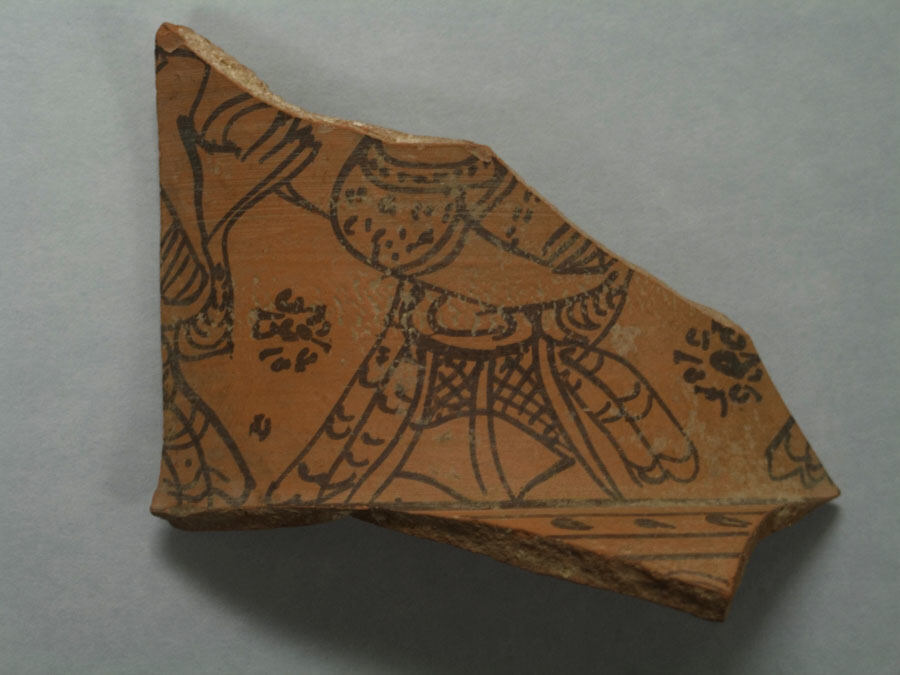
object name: shard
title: Shard from the Neck of a Vessel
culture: pakistani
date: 301-500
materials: terracotta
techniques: painting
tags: gandhara